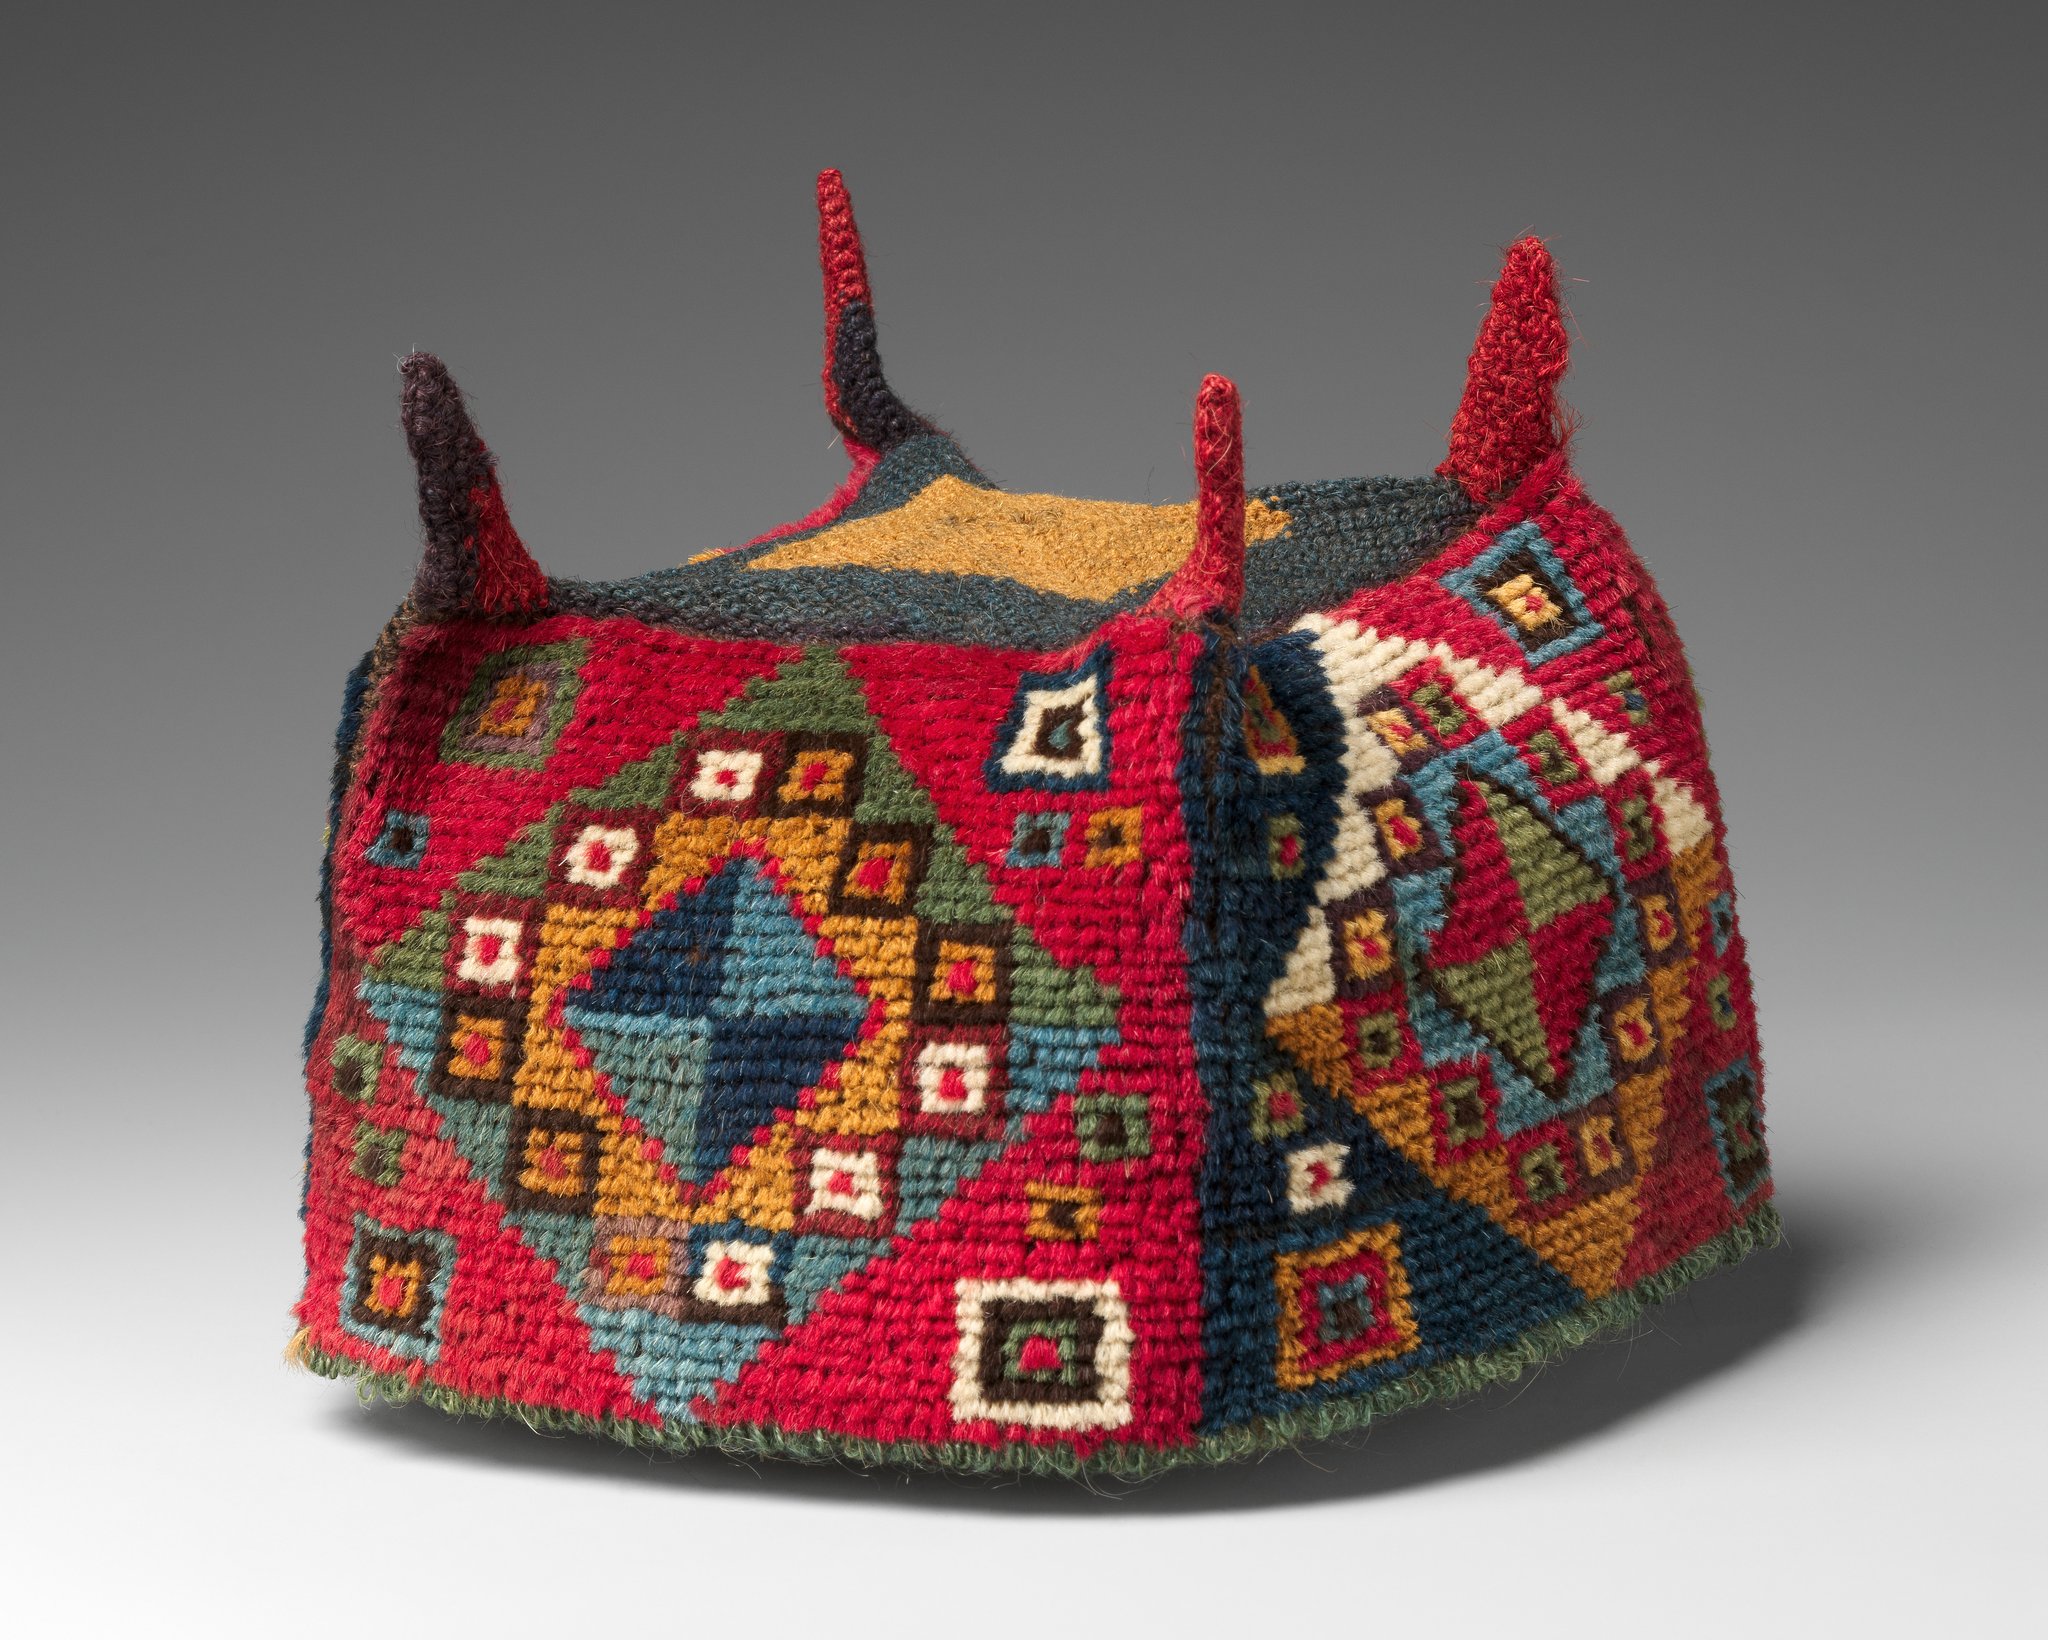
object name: hat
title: Four-Cornered Hat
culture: wari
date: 500-900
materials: animal fiber, fiber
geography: peru